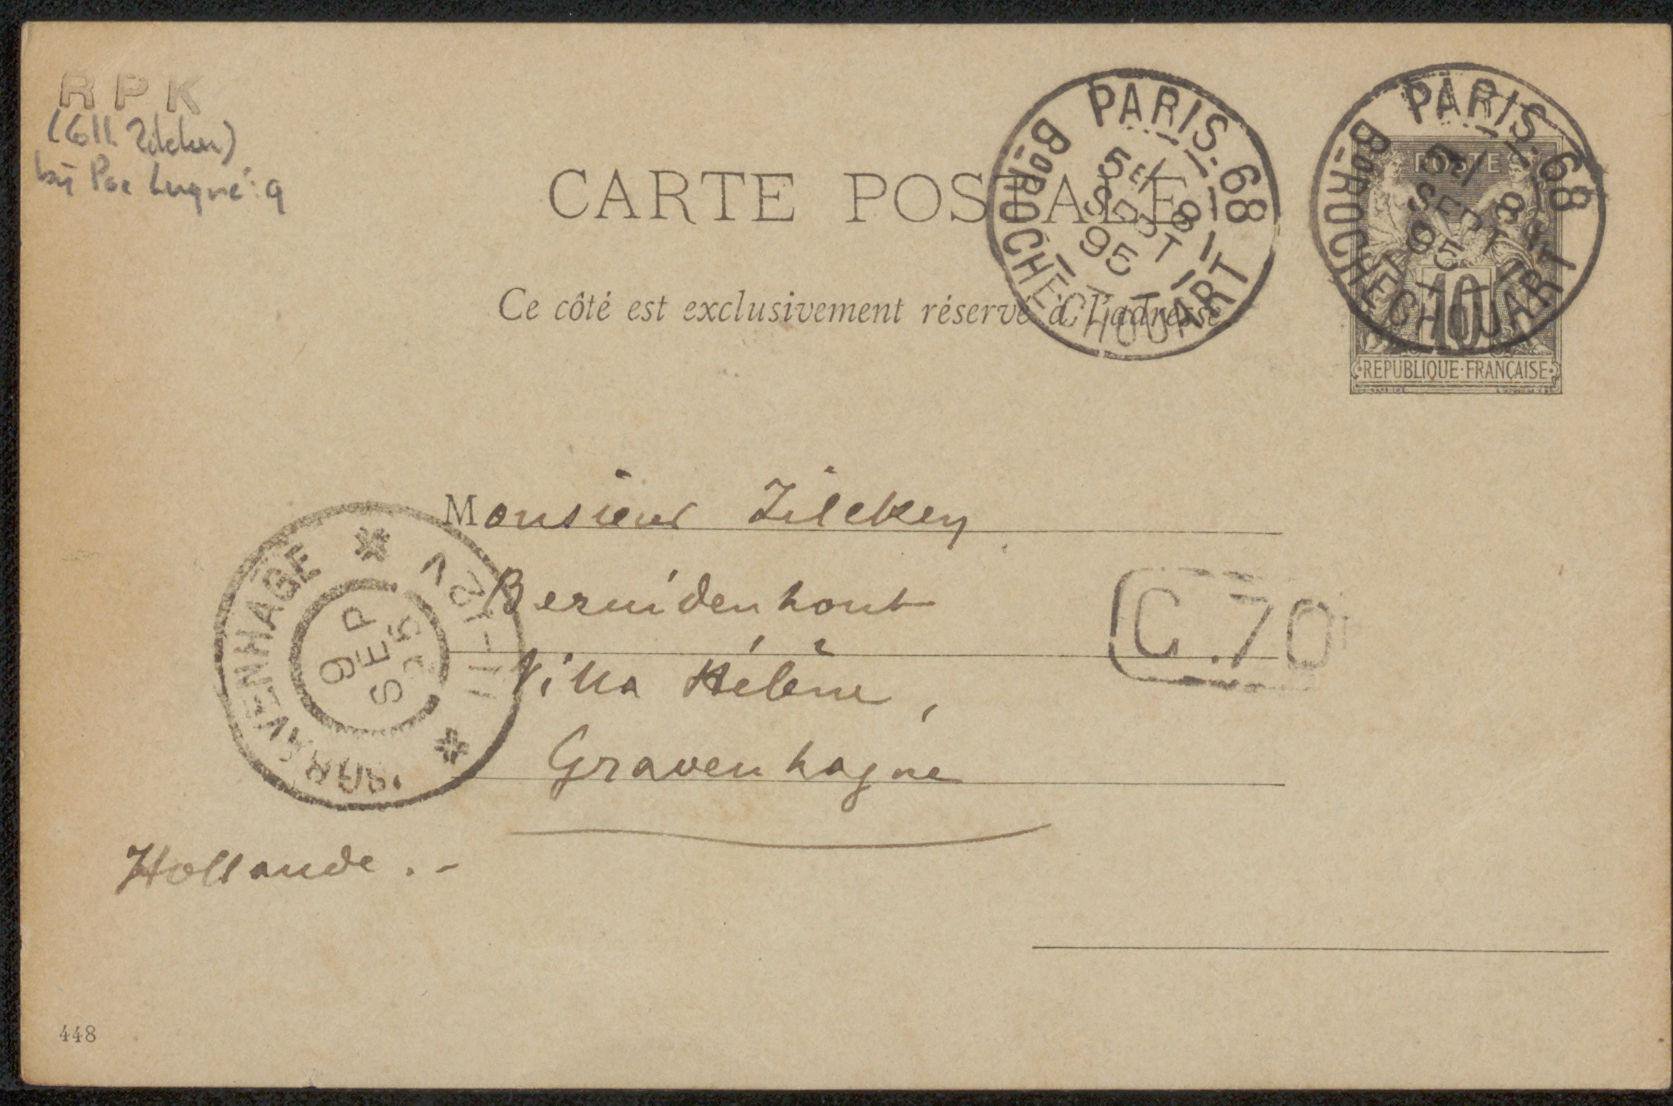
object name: postcard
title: Briefkaart aan Philip Zilcken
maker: lugné-poe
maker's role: acteur, theaterdirecteur, theatervormgever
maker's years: 1869-1940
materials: cardboard, ink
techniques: pen, writing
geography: paris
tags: frank van der goes, c.f. van der horst, painter, draughtsman, philip zilcken, the hague, amsterdam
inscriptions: collector's mark: ‘RPK’